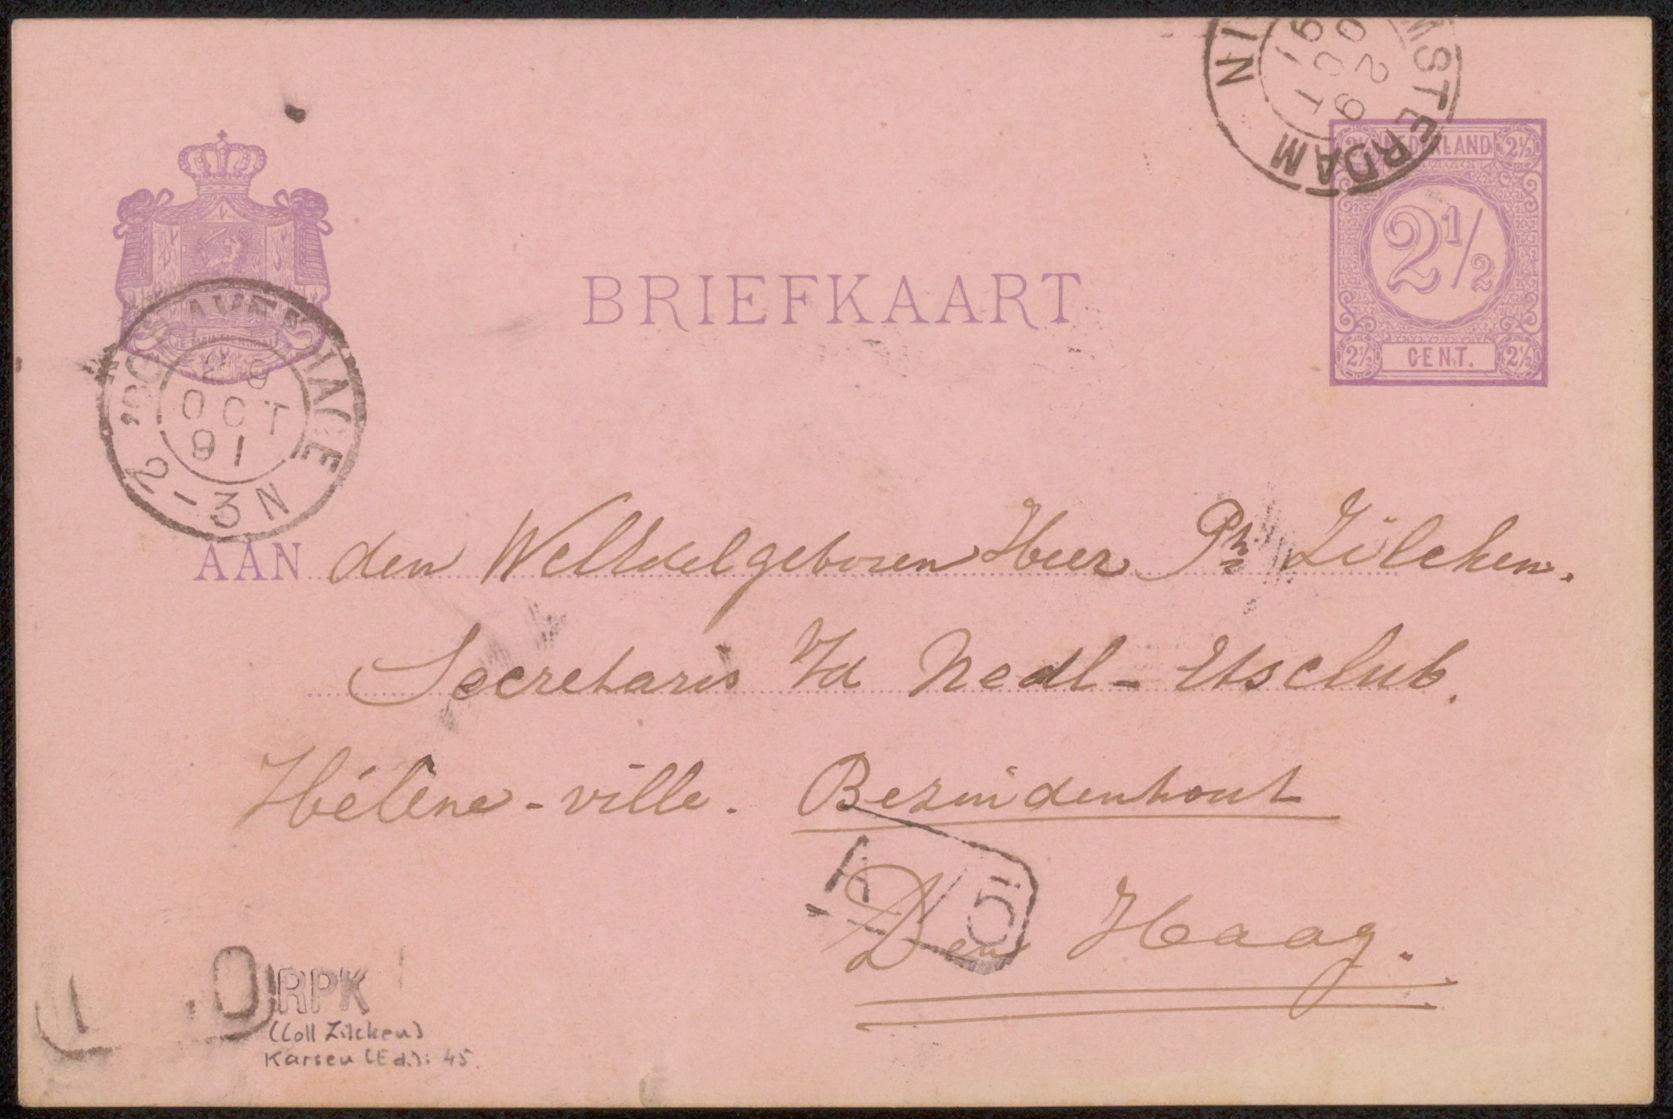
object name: postcard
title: Briefkaart aan Philip Zilcken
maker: eduard karsen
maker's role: draughtsman, painter, print maker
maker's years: 1860-1941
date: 1891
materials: cardboard, ink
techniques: pen, writing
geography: amsterdam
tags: nijmegen, print maker, adriaan pit, martinus mouton, the hague, painter, draughtsman, philip zilcken, the graphic arts, money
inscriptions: collector's mark: ‘RPK’